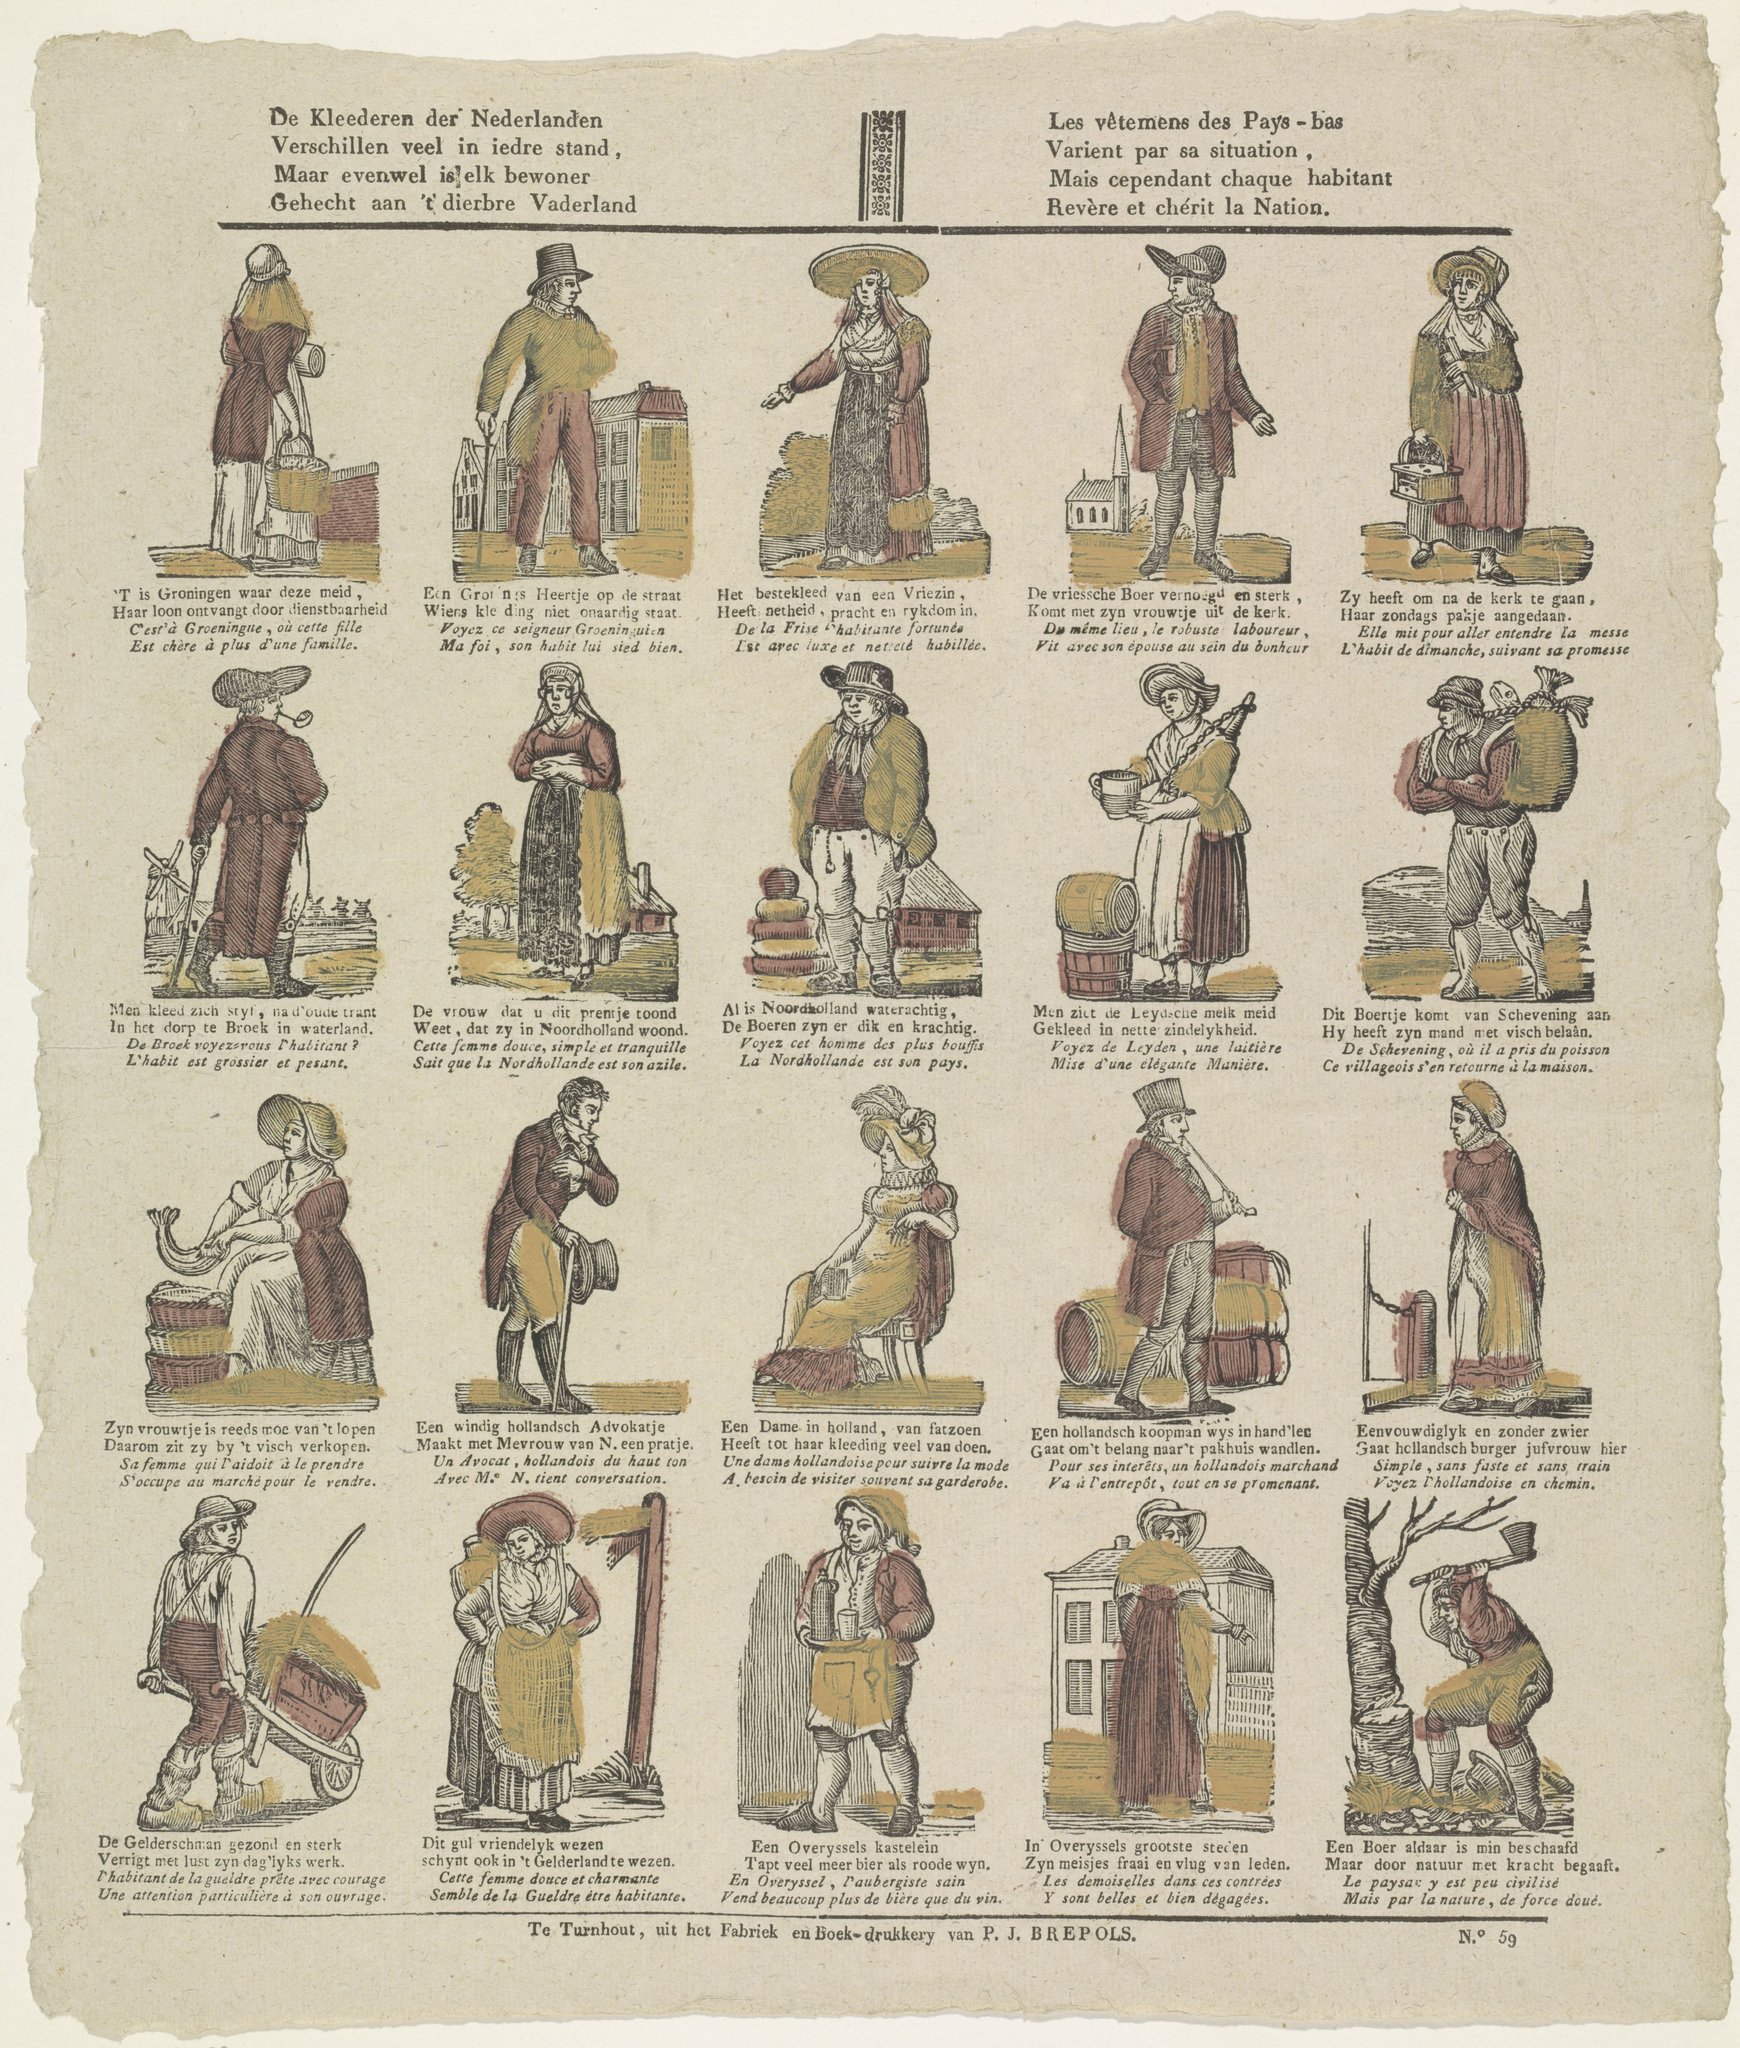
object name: popular print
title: De kleederen der Nederlanden / Verschillen veel in iedre stand [(...)]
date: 1800-1833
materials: paper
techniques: colour, letterpress printing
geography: turnhout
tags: historical costume, folk costume, regional costume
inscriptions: collector's mark: Lugt 2760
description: Blad met 20 voorstellingen van personen in verschillende Nederlandse klederdrachten. Onder elke afbeelding een tweeregelig vers in het Nederlands en in het Frans. Genummerd rechtsonder: No. 59.